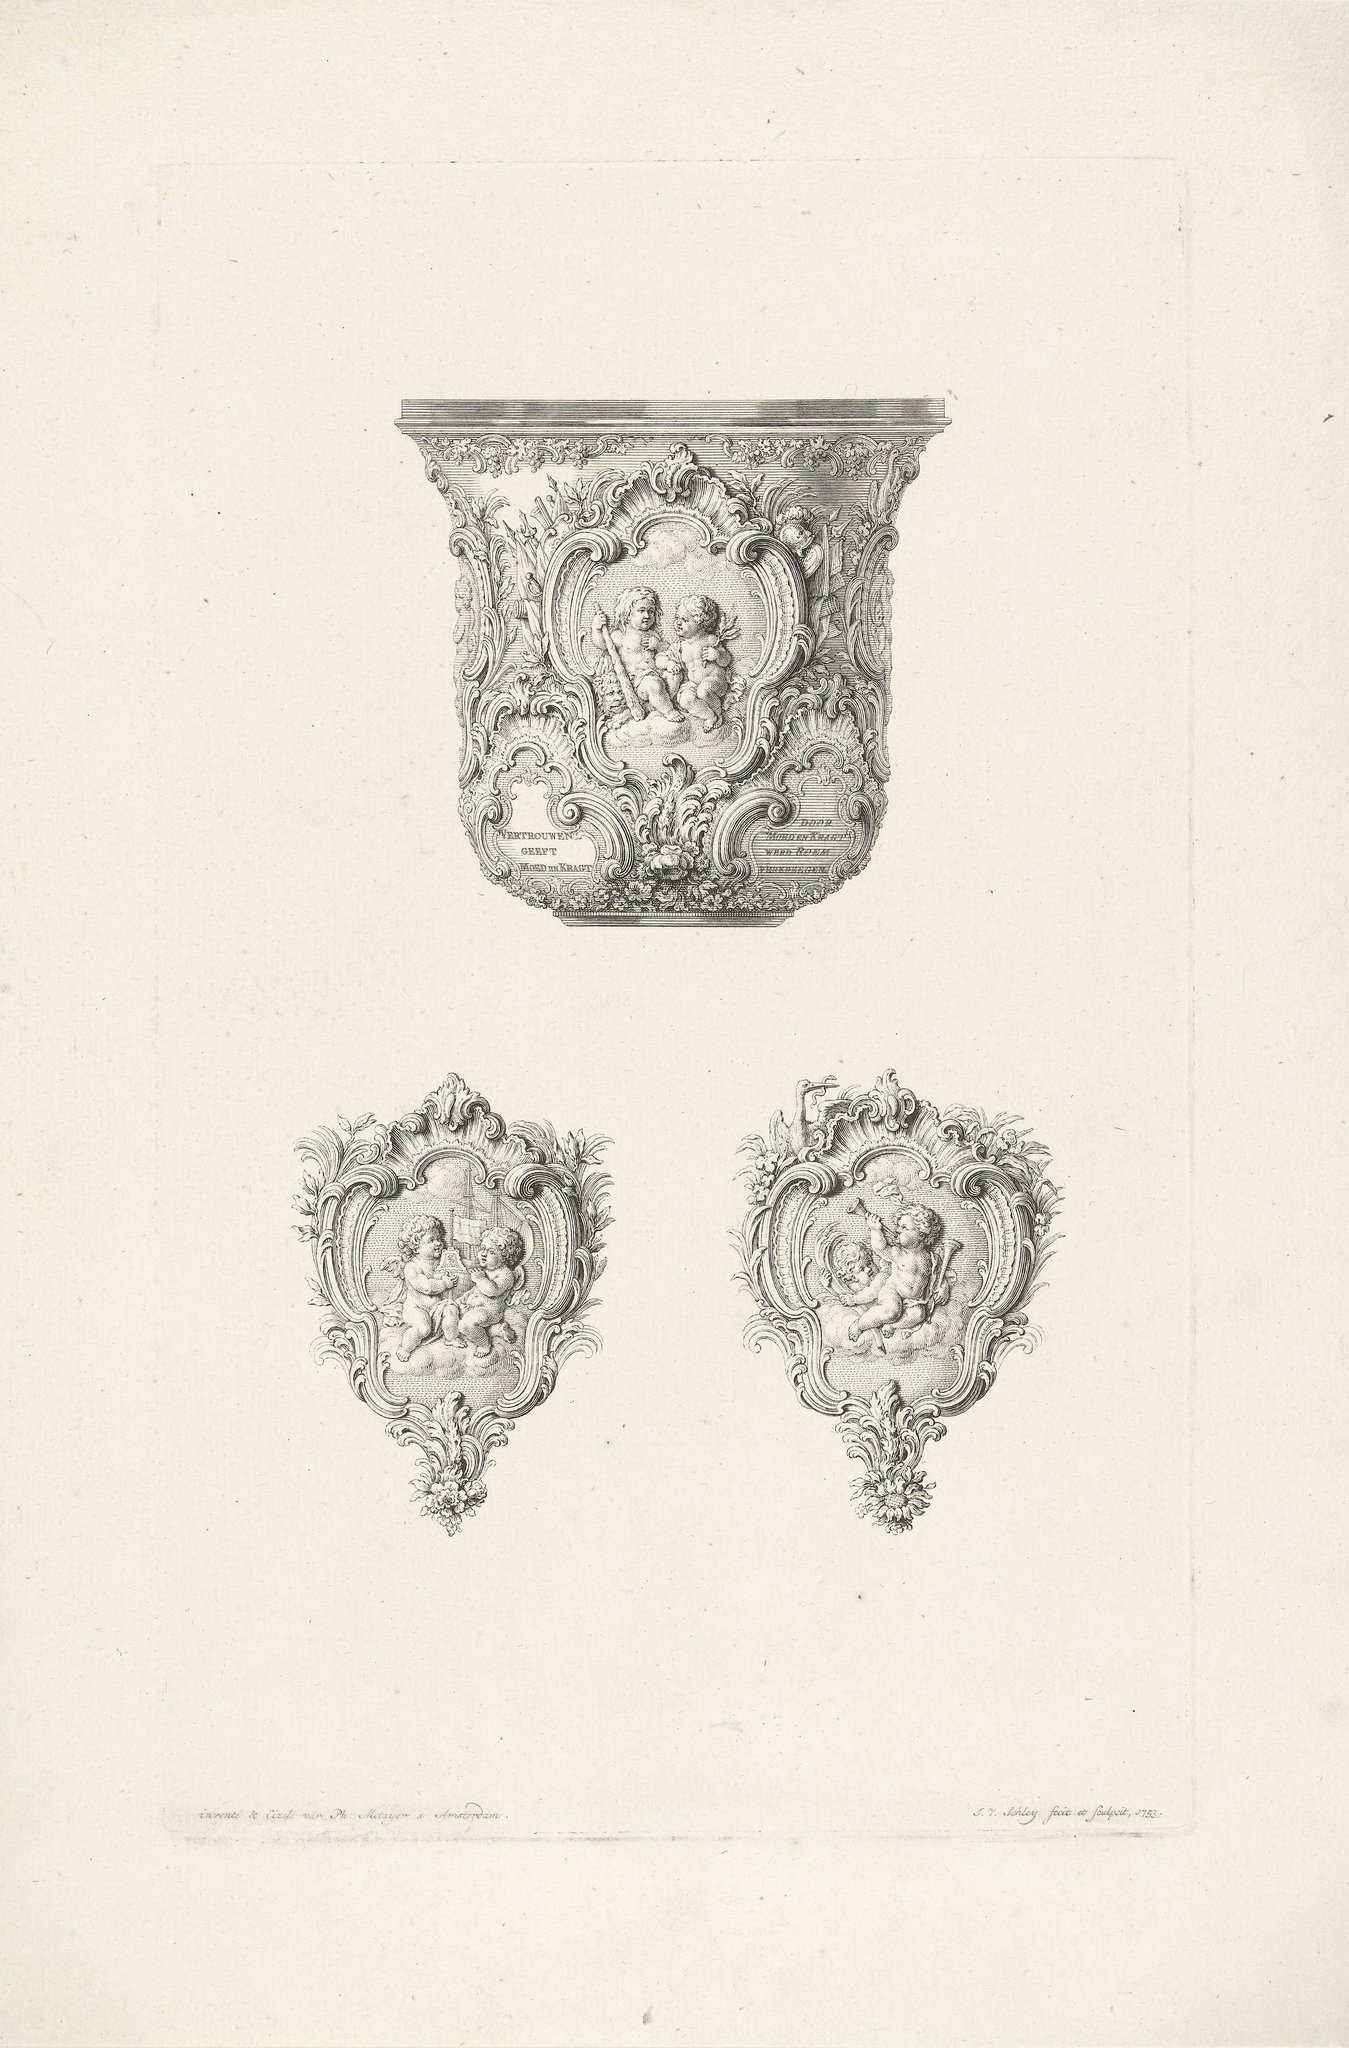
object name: print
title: Details van gouden beker van de Haagse schutterij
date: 1753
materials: paper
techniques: etching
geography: northern netherlands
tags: the hague, willem iv (prins van oranje-nassau), anna van hannover, cup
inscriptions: collector's mark: Lugt 2228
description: Een gouden beker door stadhouder Willem IV toegezegd aan de Haagse schutterij en na zijn dood gepresenteerd door prinses Anna op 8 mei 1753. Blad met drie details van de voorstellingen op de beker en de inscriptie aangebracht aan de binnenzijde van de deksel. De beker vervaardigd door Philippe Métayer te Amsterdam.